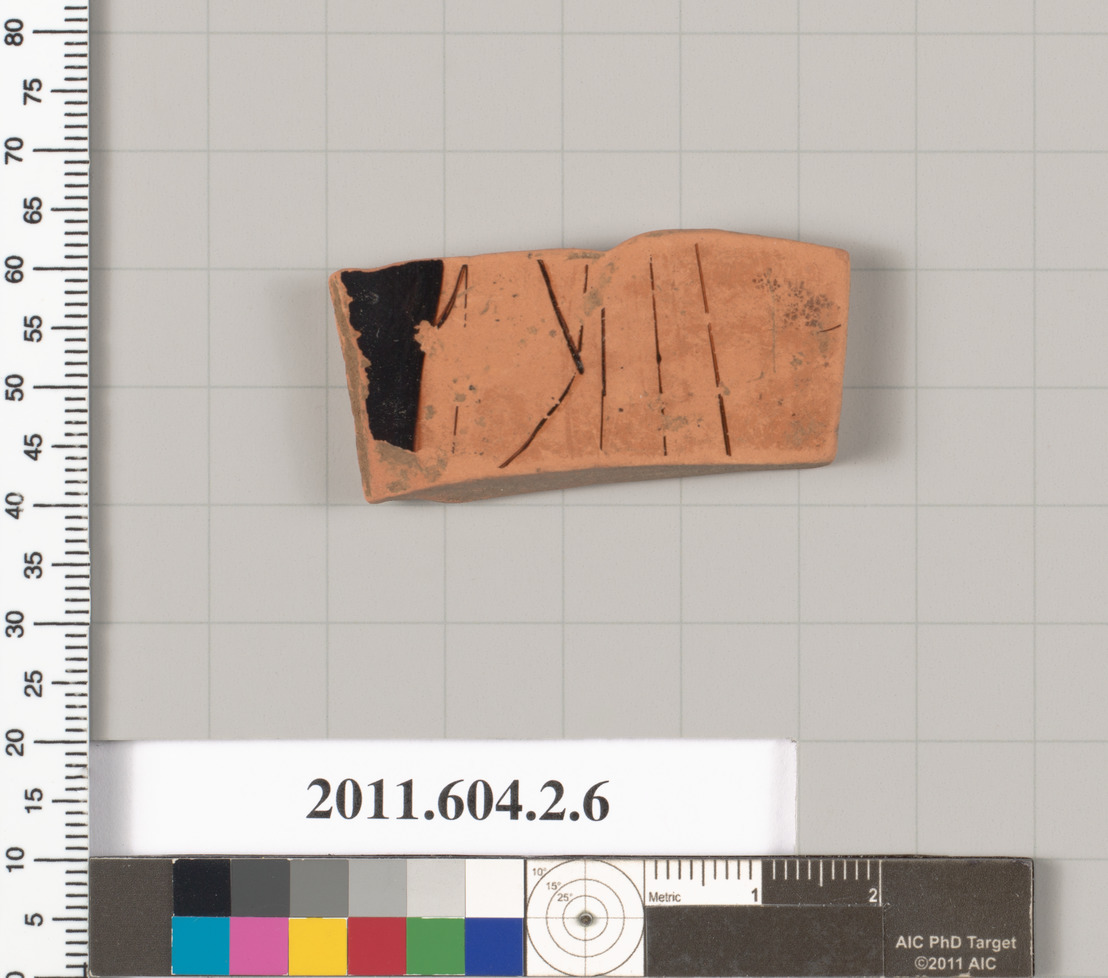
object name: neck amphora fragment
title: Terracotta fragment of a neck-amphora (jar)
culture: greek, attic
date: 475-451 BCE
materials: terracotta